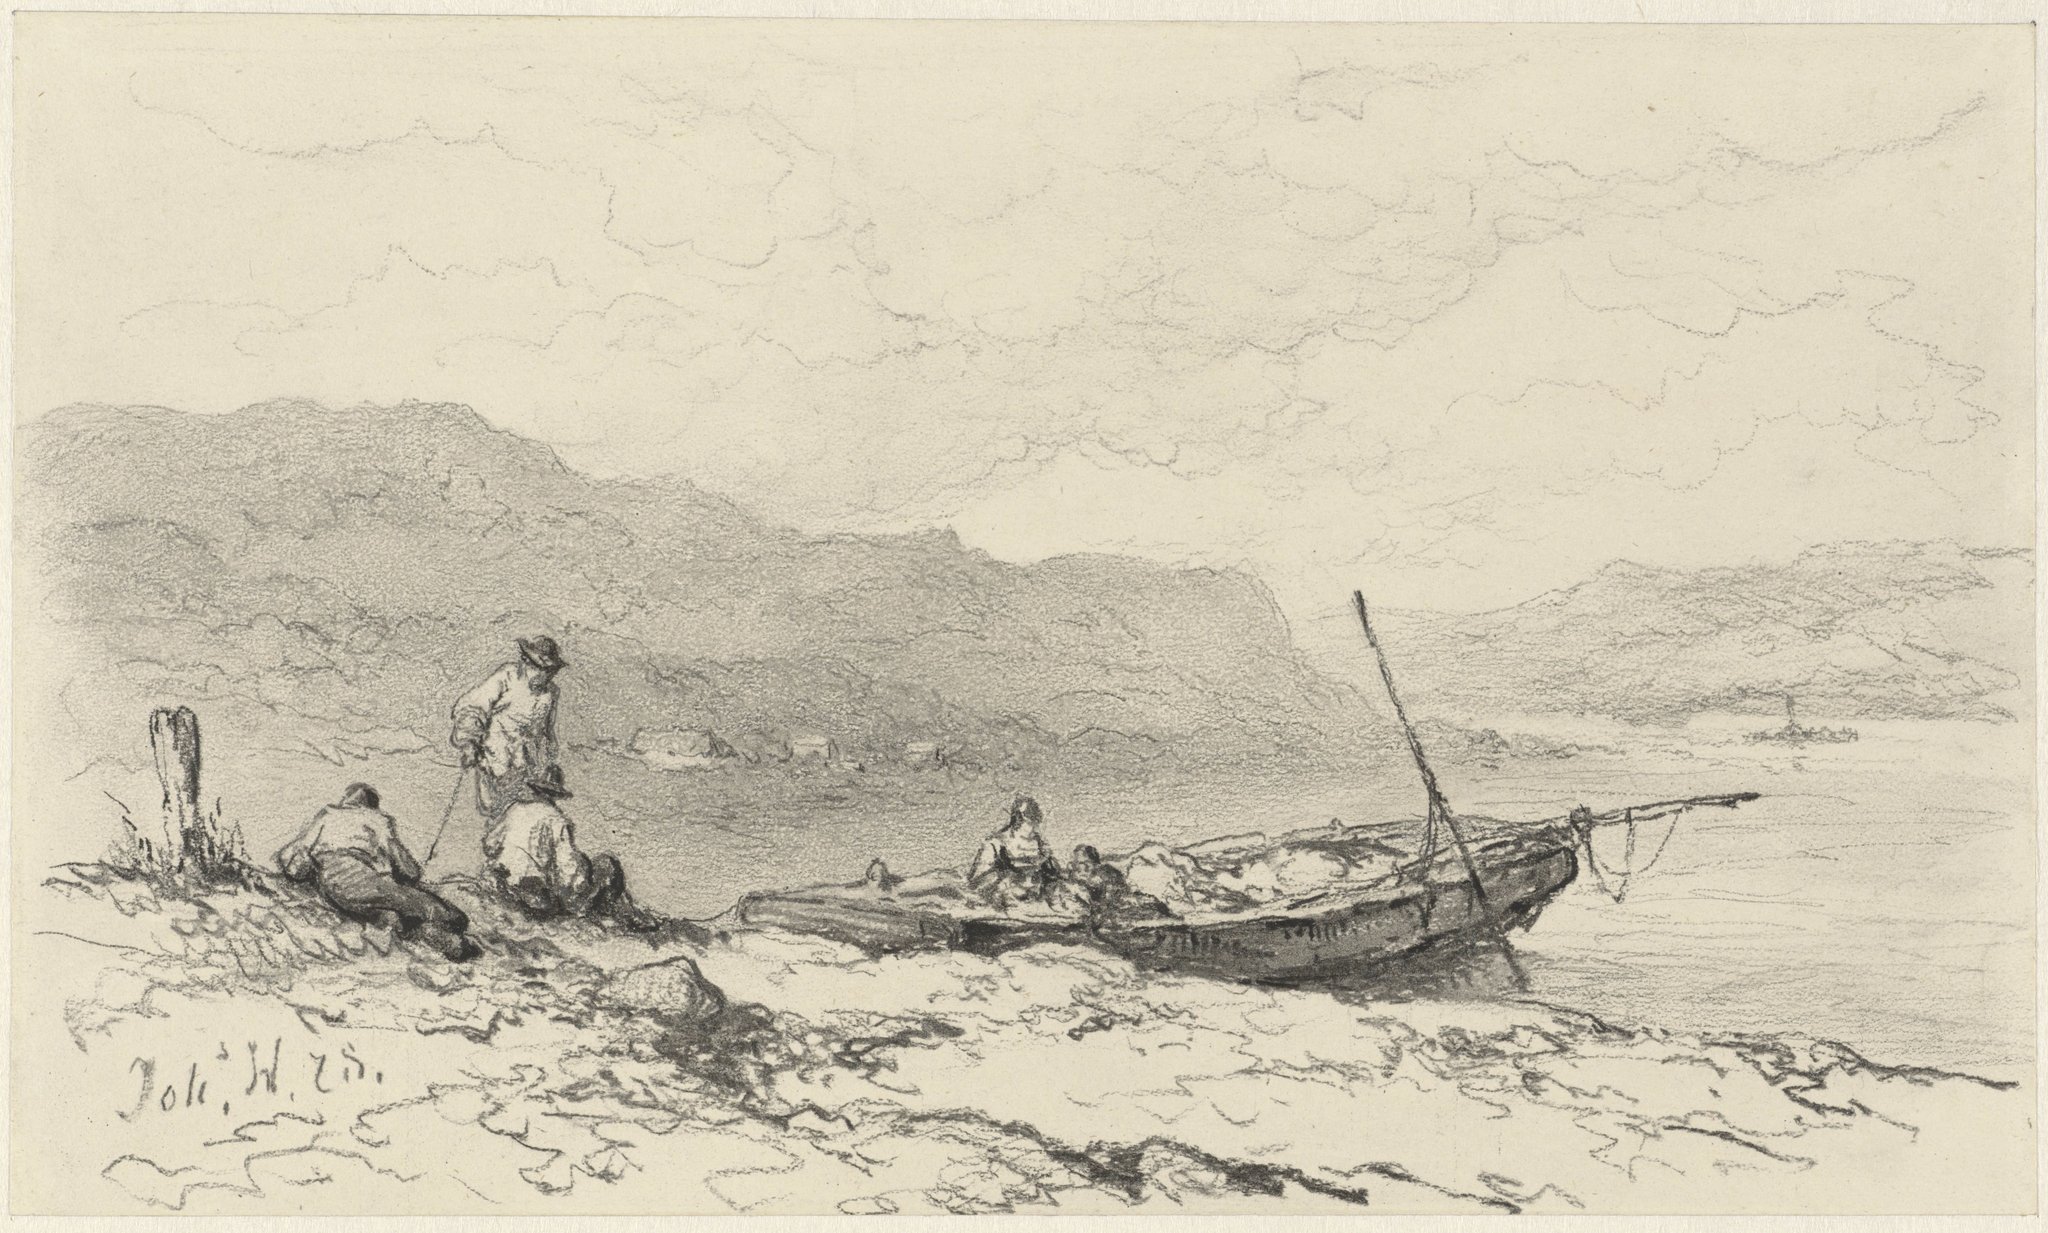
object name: drawing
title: Figuren bij een platte schuit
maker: johannes hilverdink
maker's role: draughtsman, painter, print maker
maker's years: 1813-1902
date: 1878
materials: chalk, paper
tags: landscapes in the temperate zone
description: Figuren bij een platte schuit aan de oever van een meer in bergachtig landschap.